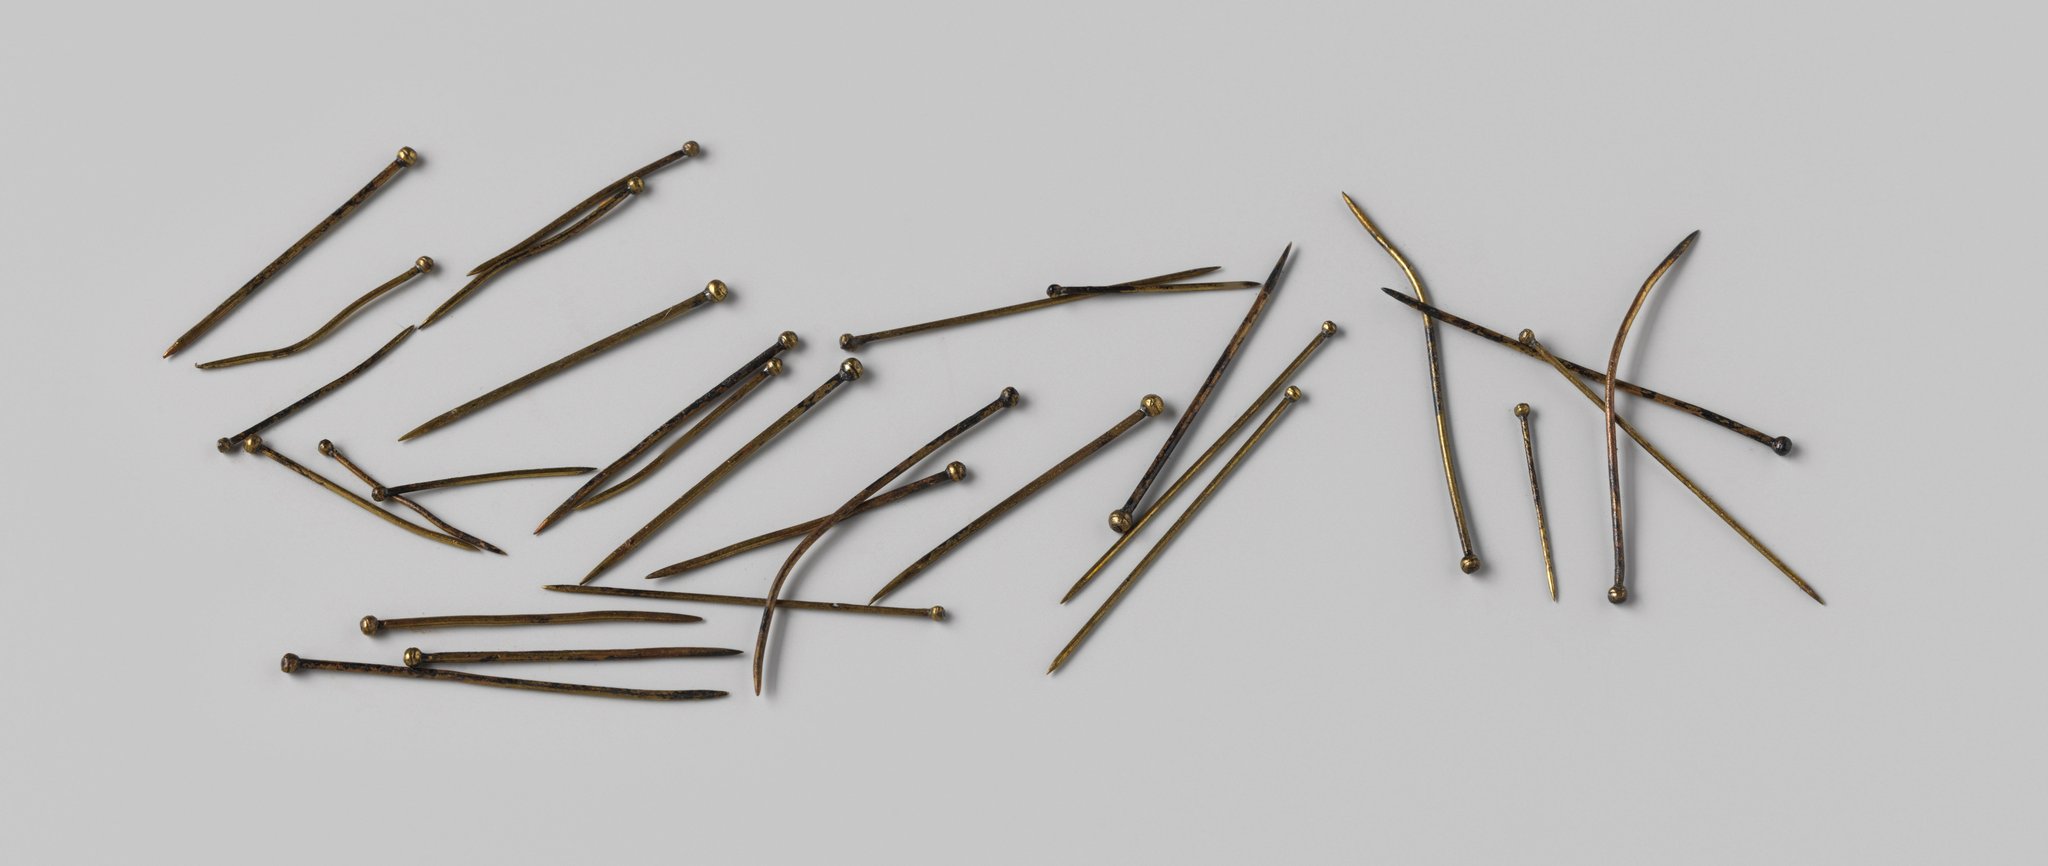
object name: pin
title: Koperen spelden uit het wrak van de Oost-Indiëvaarder Hollandia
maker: Anonymous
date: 1700-1743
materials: stone, copper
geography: netherlands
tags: verenigde oostindische compagnie, hollandia (schip), annet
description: Koperen spelden, gevonden in contrectie.